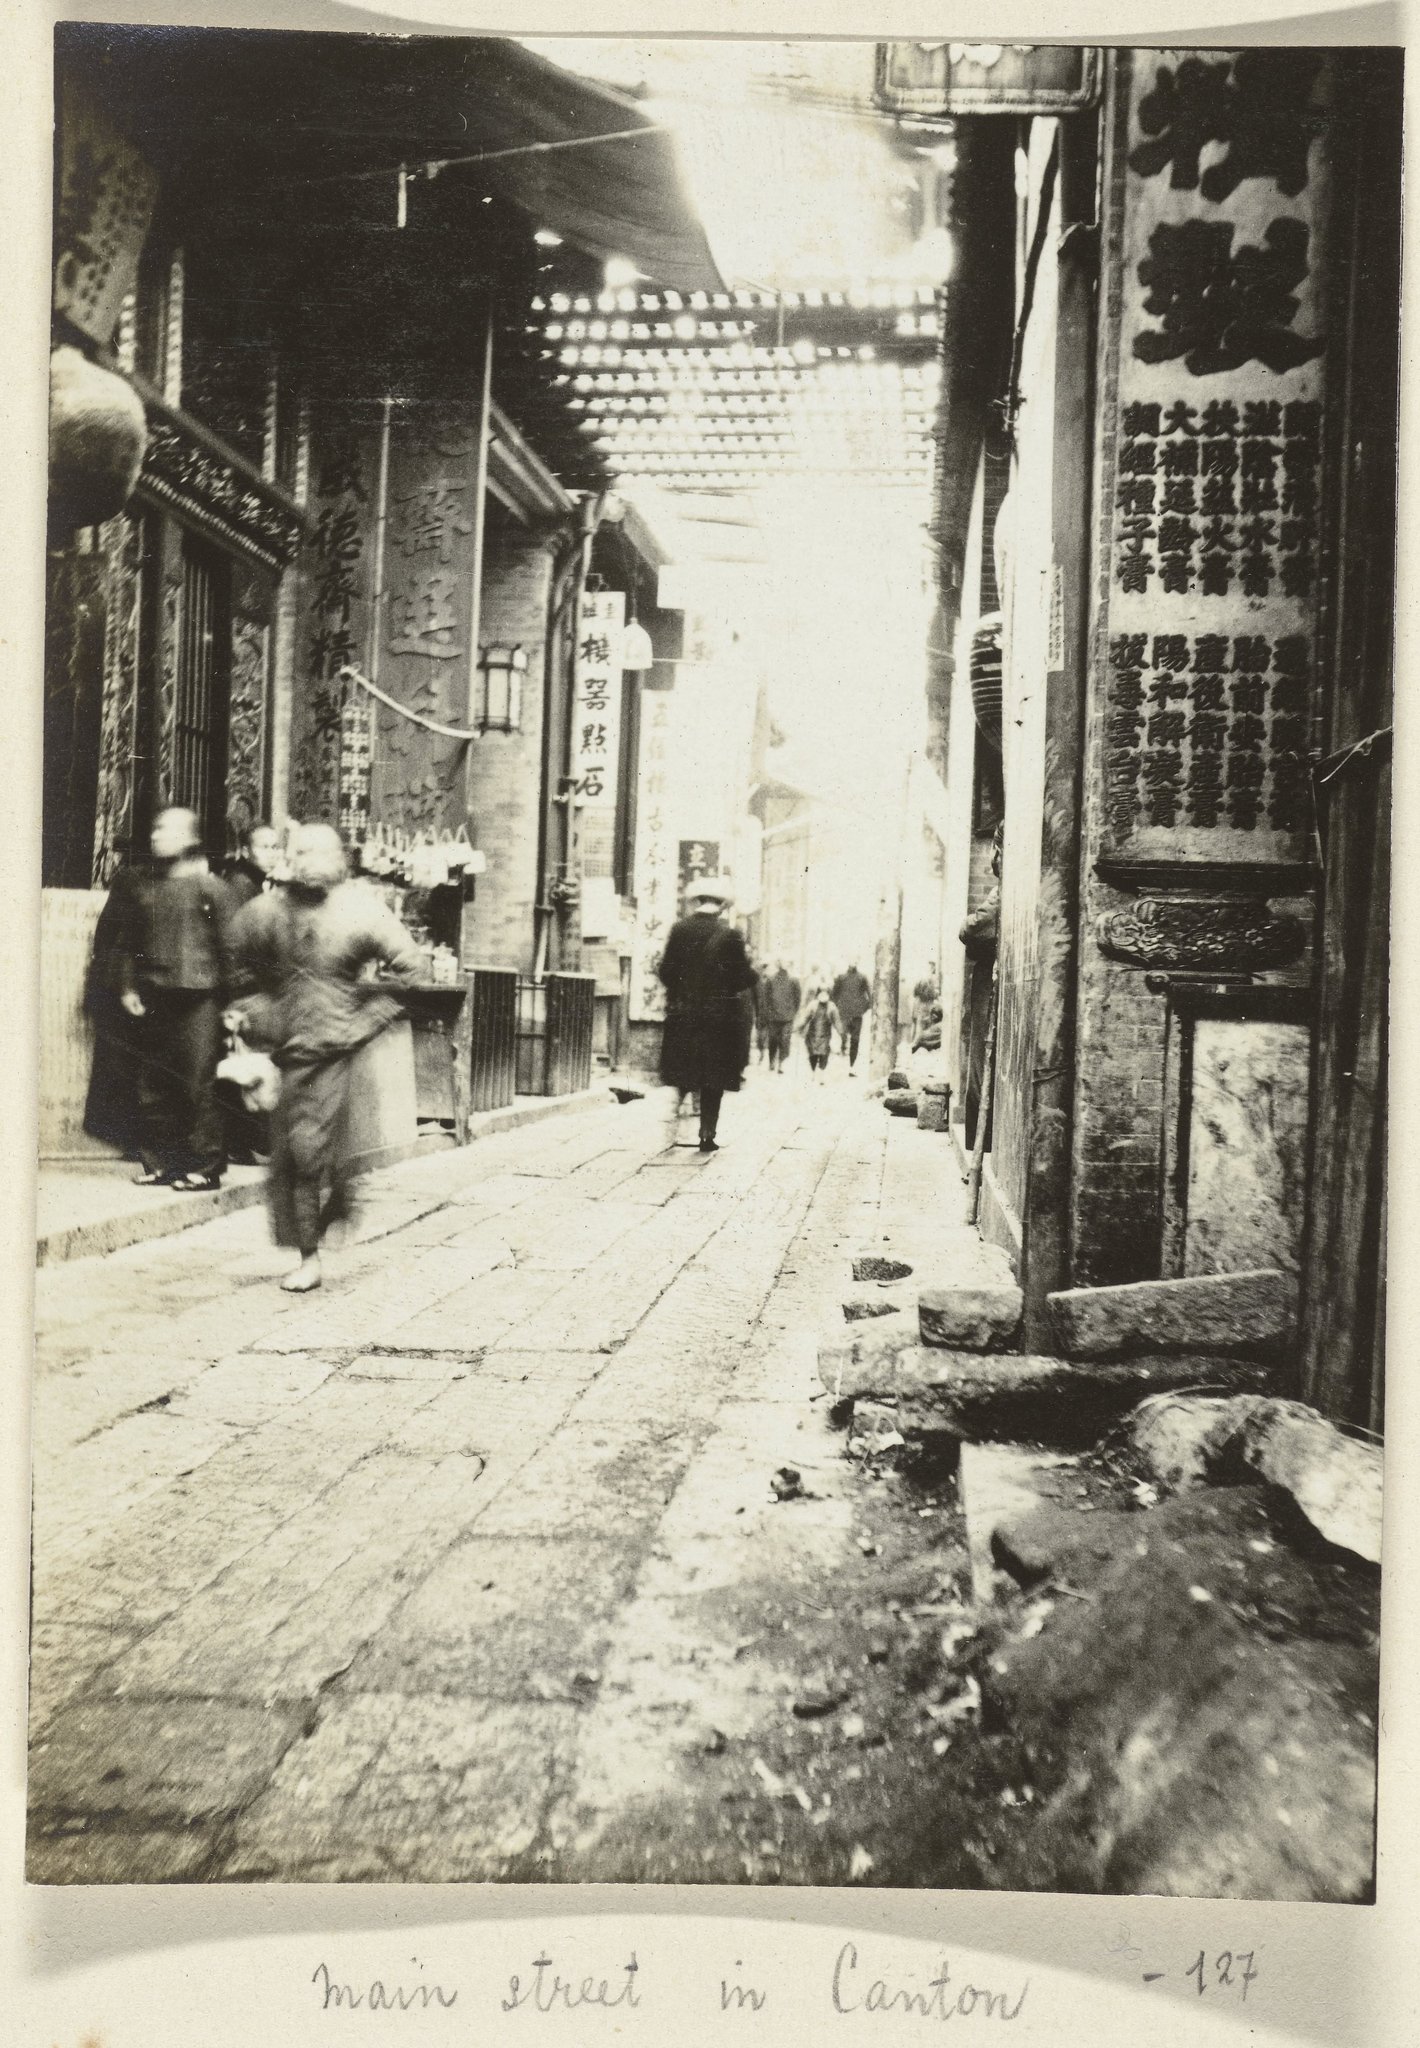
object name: photograph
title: Straatgezicht in Kanton met aan weerszijden winkelpuien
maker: geldolph adriaan kessler (dolph)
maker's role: fotograaf, industrieel, voetballer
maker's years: 1884-1945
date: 1903-1908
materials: cardboard, photographic support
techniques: gelatin silver print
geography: guangdong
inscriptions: title: ‘Main street in Canton’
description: Straatgezicht in Kanton met aan weerszijden winkelpuien. Onderdeel van het fotoalbum van Dolph Kessler met opnamen die hij maakte tijdens zijn verblijf in Engeland en op een wereldreis die hij als secretaris van Henri Deterding (directeur Koninklijke Olie) ondernam naar Nederlands-Indië, Japan, China en de Verenigde Staten, tussen 1906 en 1908.